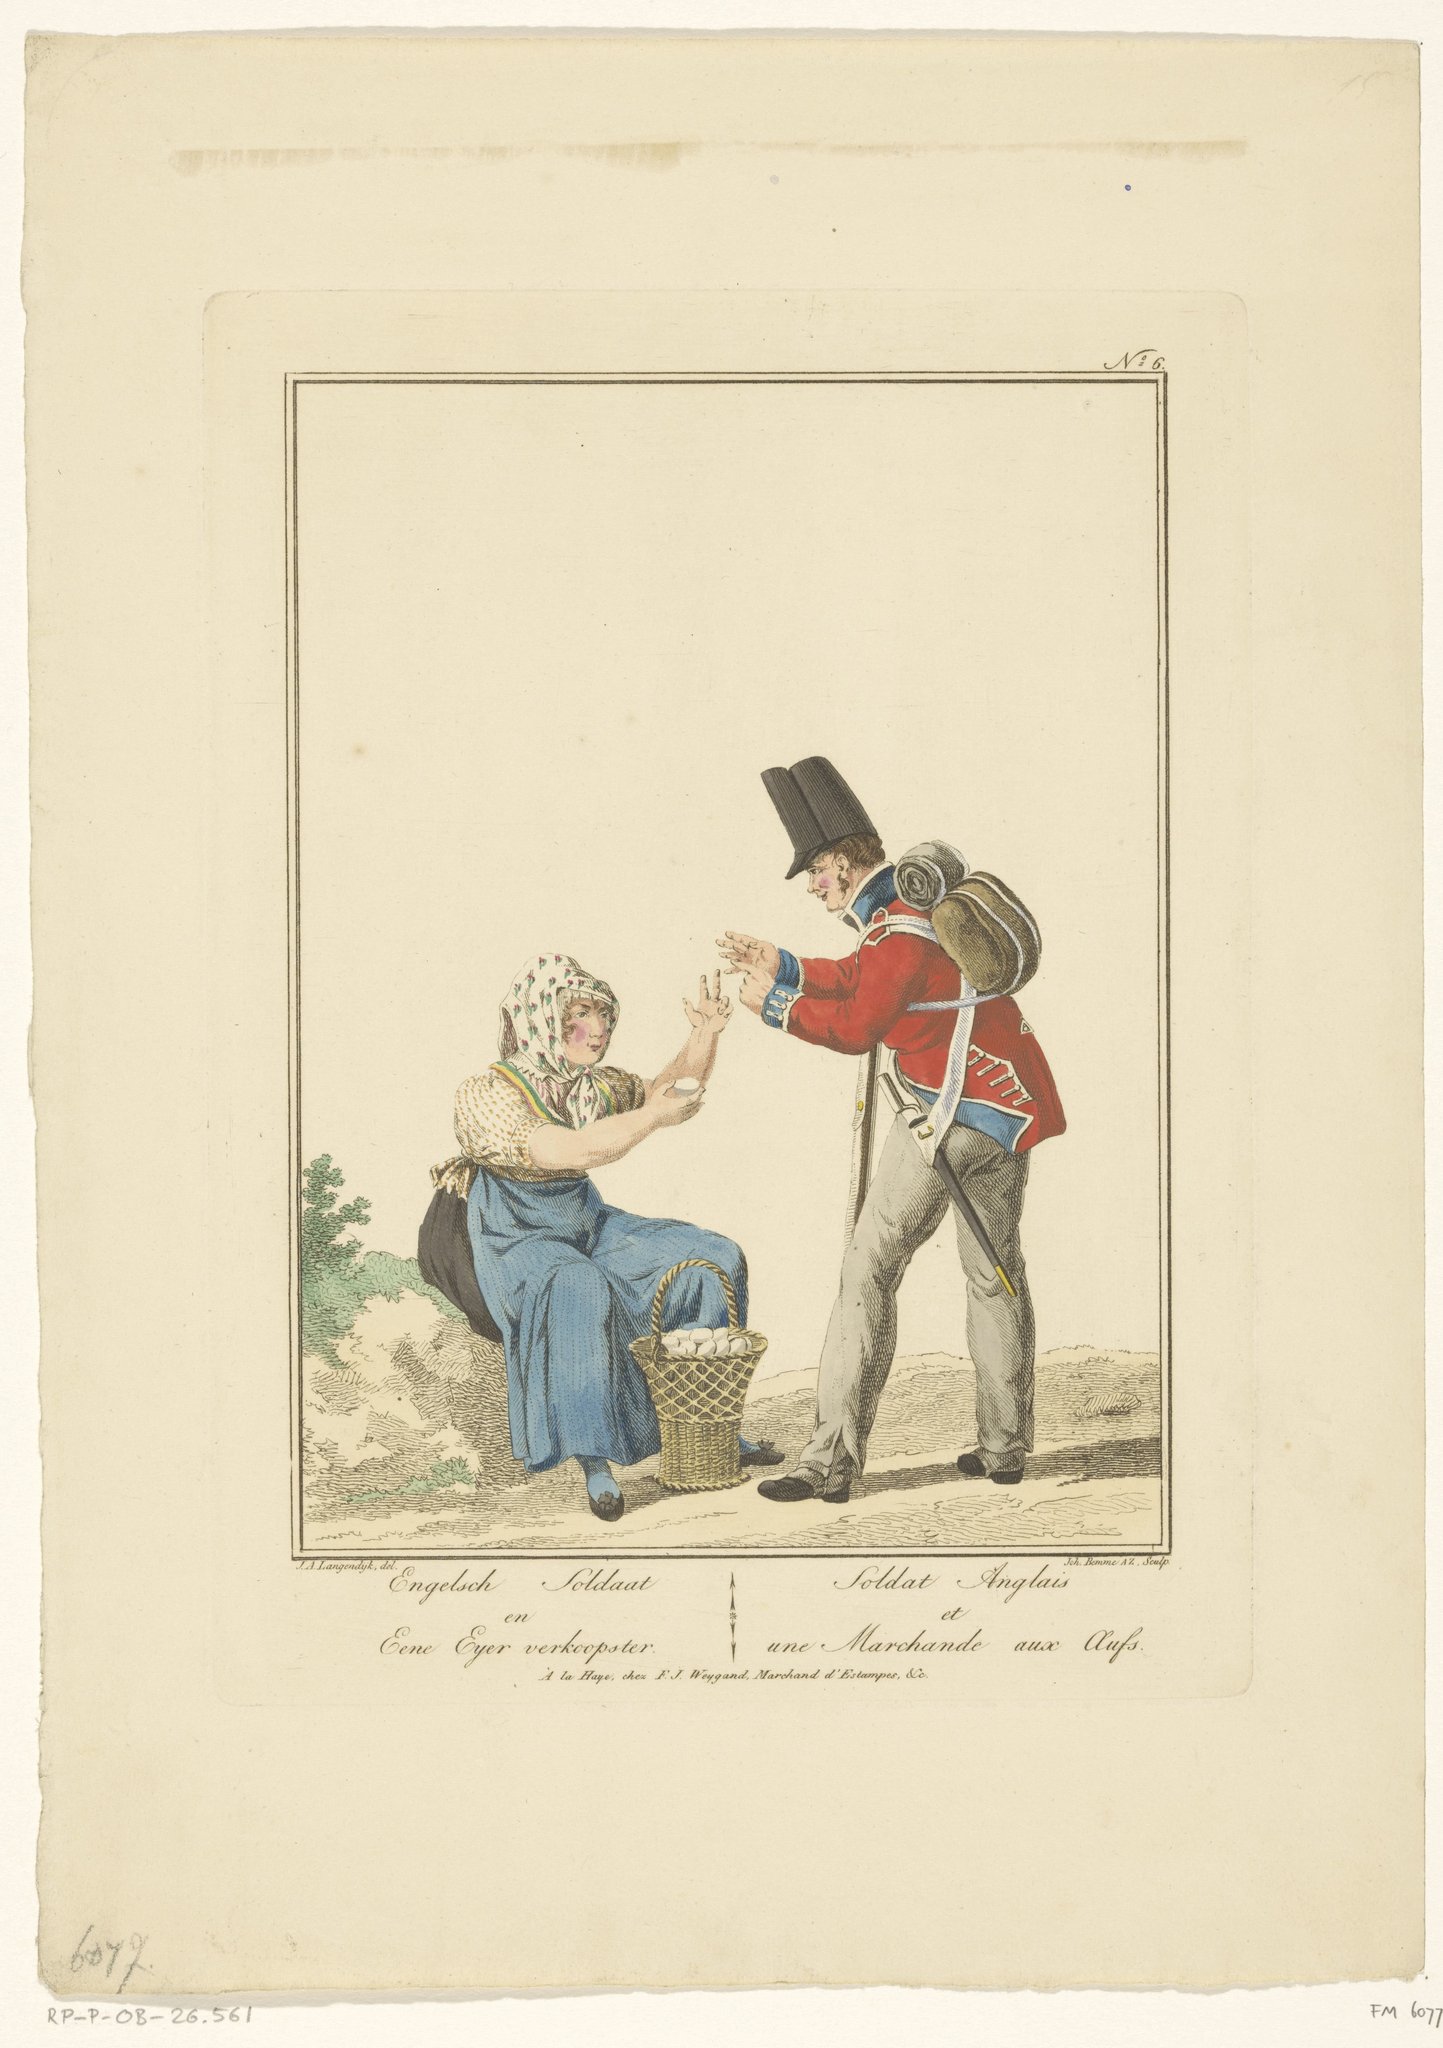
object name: print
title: Engelsch Soldaat en eene eyer verkoopster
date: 1800-1841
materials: paper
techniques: etching, hand coloring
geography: rotterdam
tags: street-trader - bb - women engaged in trade and commerce, folk costume, regional costume, (military) uniforms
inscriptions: collector's mark: Lugt 2228